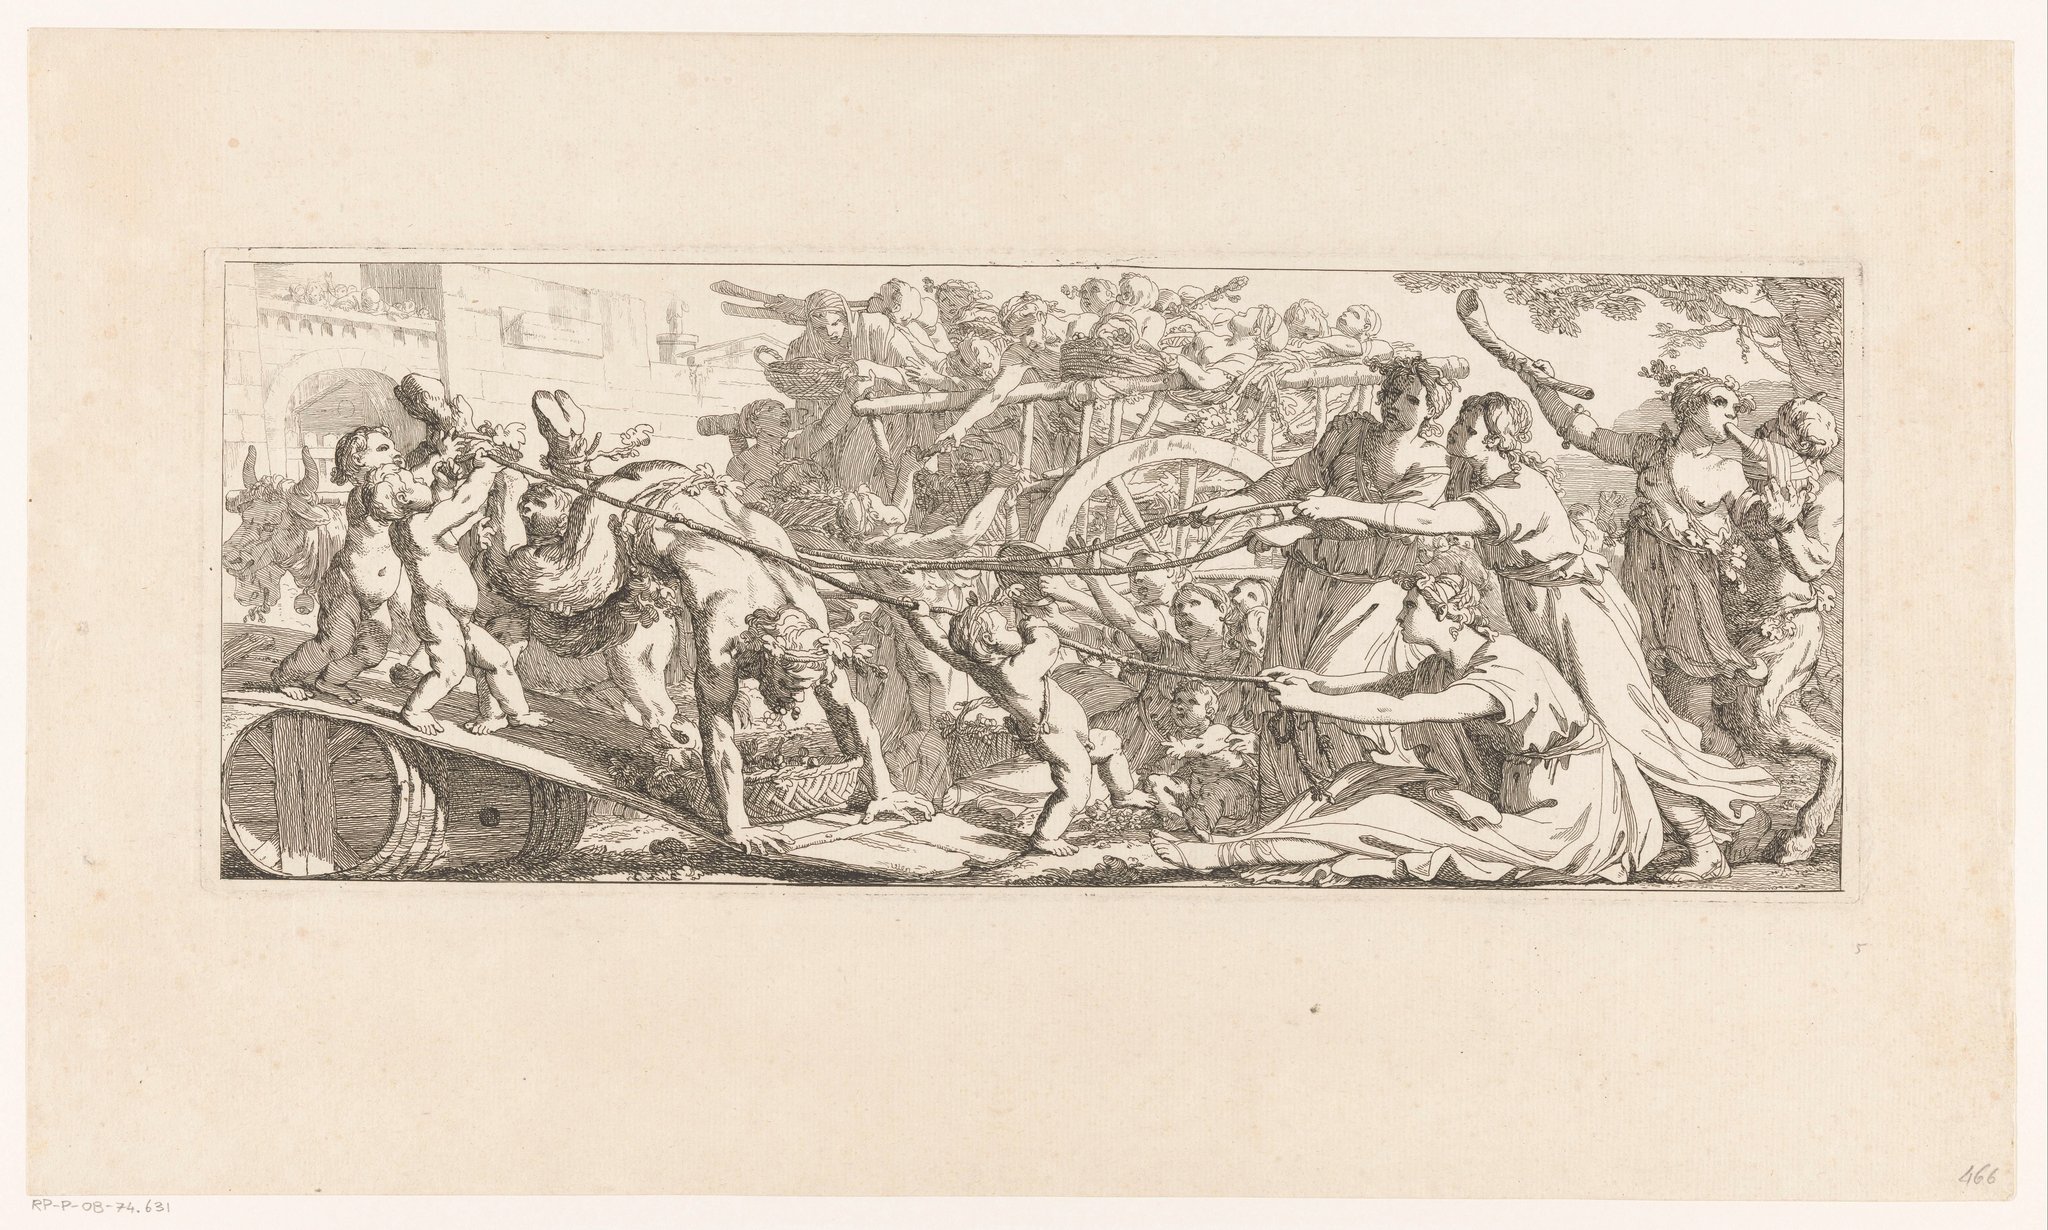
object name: print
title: Terugkeer van de wijnoogst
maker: joseph-marie vien (i)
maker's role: painter, print maker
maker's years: 1716-1809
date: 1750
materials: paper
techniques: etching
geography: rome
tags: maenad(s), female bacchant(es), male bacchant(es), satyr(s) (in general), grape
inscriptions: collector's mark: Lugt 240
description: Bacchantische scène in friesvorm met bacchanten en saters. Midden achter wordt een kar met de oogst voortgetrokken door koeien. Links balanceert een sater op zijn handen op een plank, vastgebonden aan touwen waaraan drie jonge vrouwen trekken.